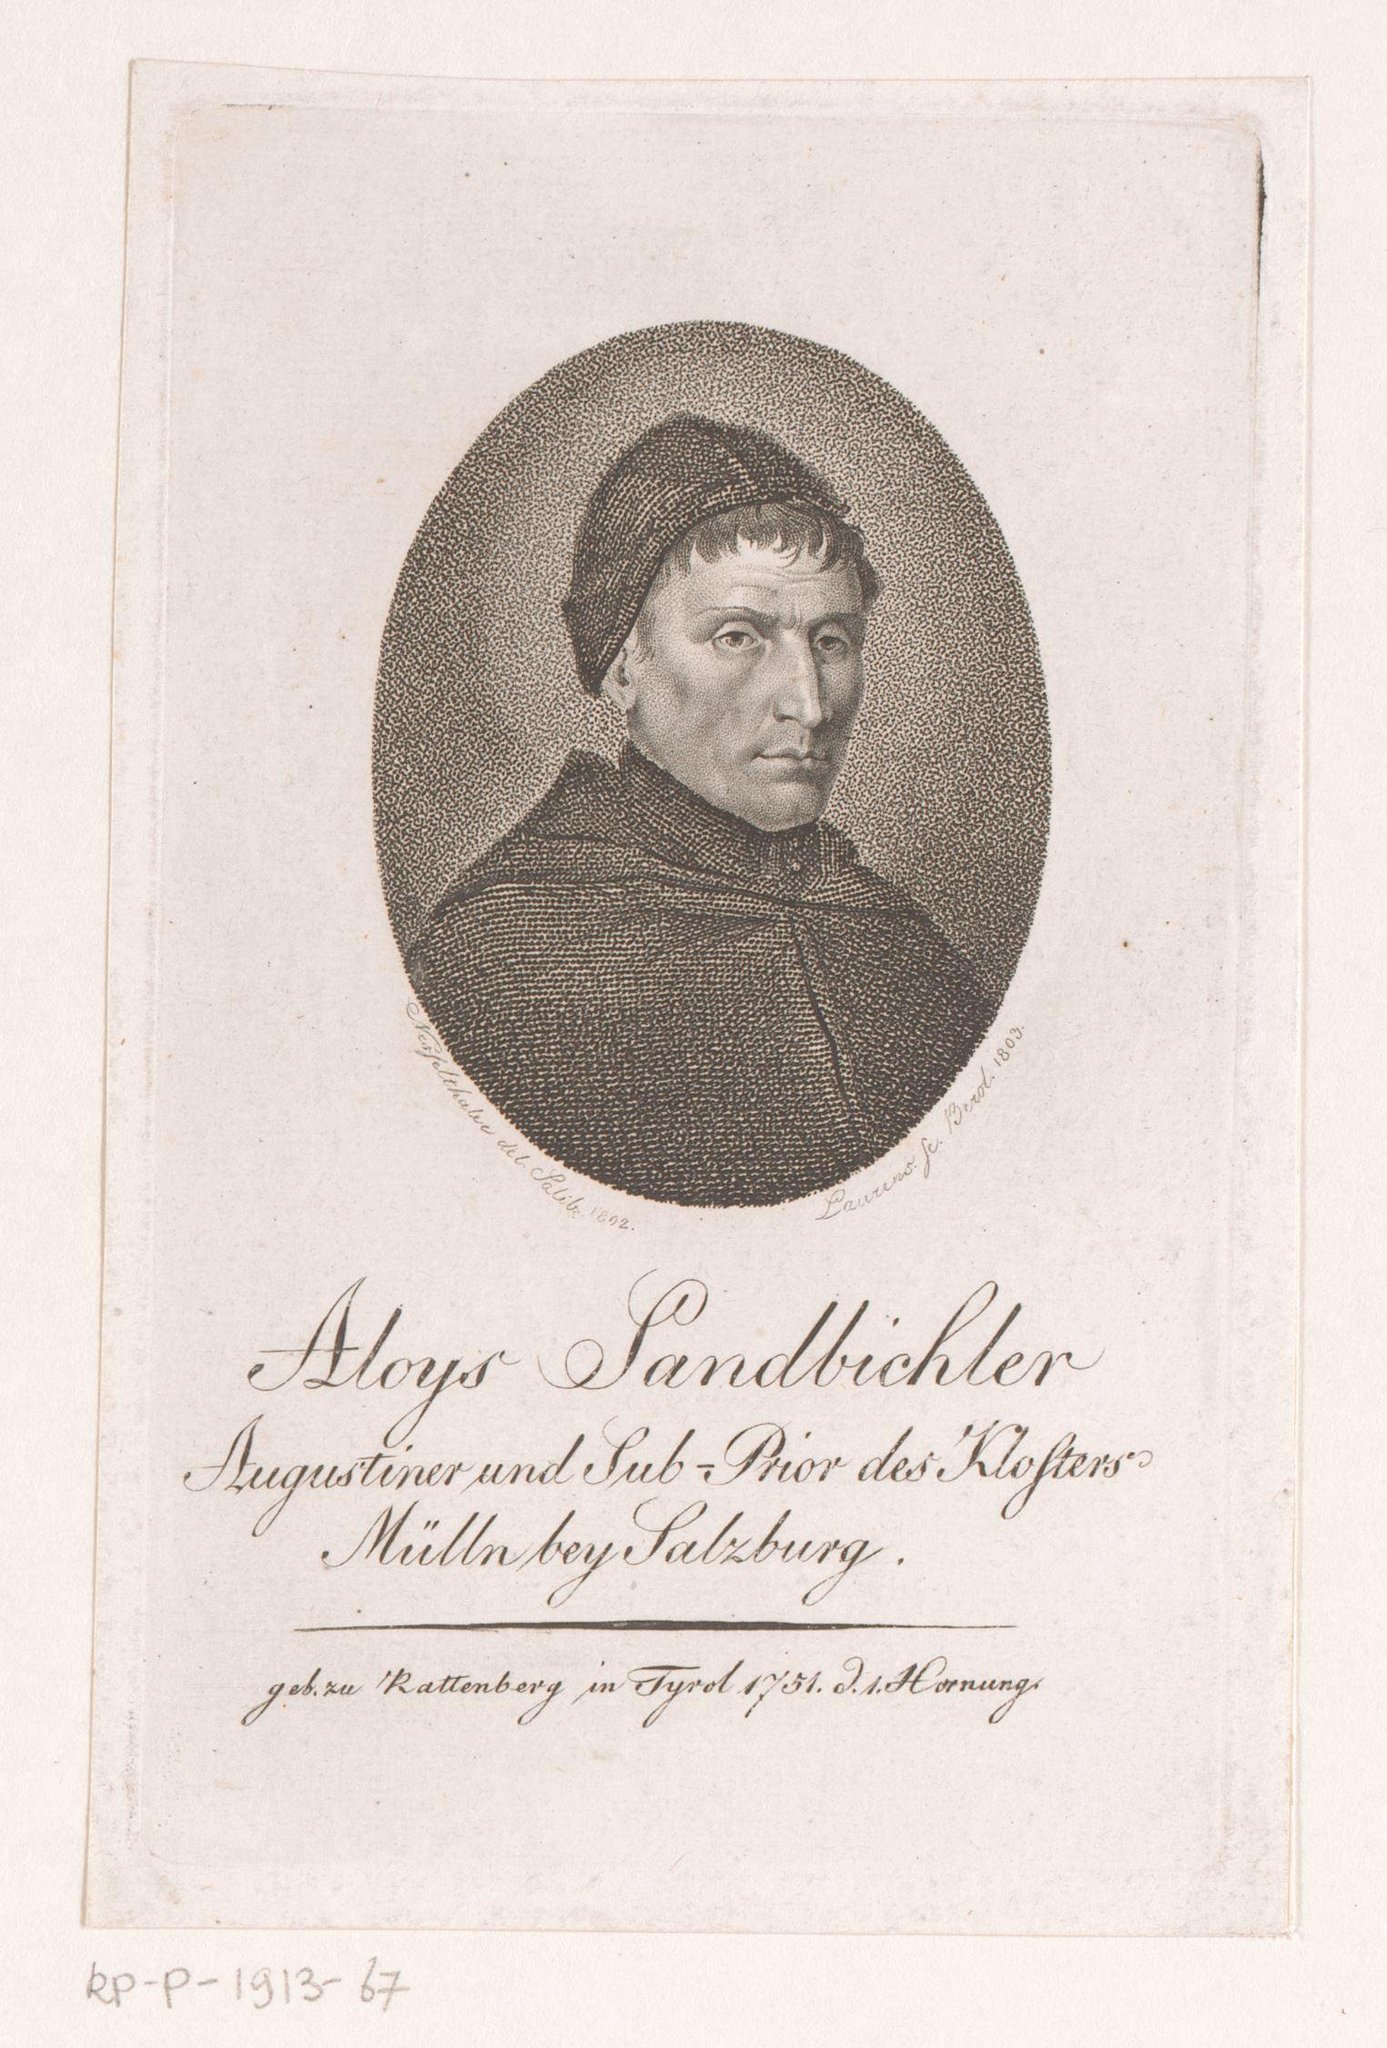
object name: print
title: Portret van Alois Sandbichler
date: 1803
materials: paper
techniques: stippling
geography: berlin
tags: theologian, historical persons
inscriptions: collector's mark: Lugt 2228